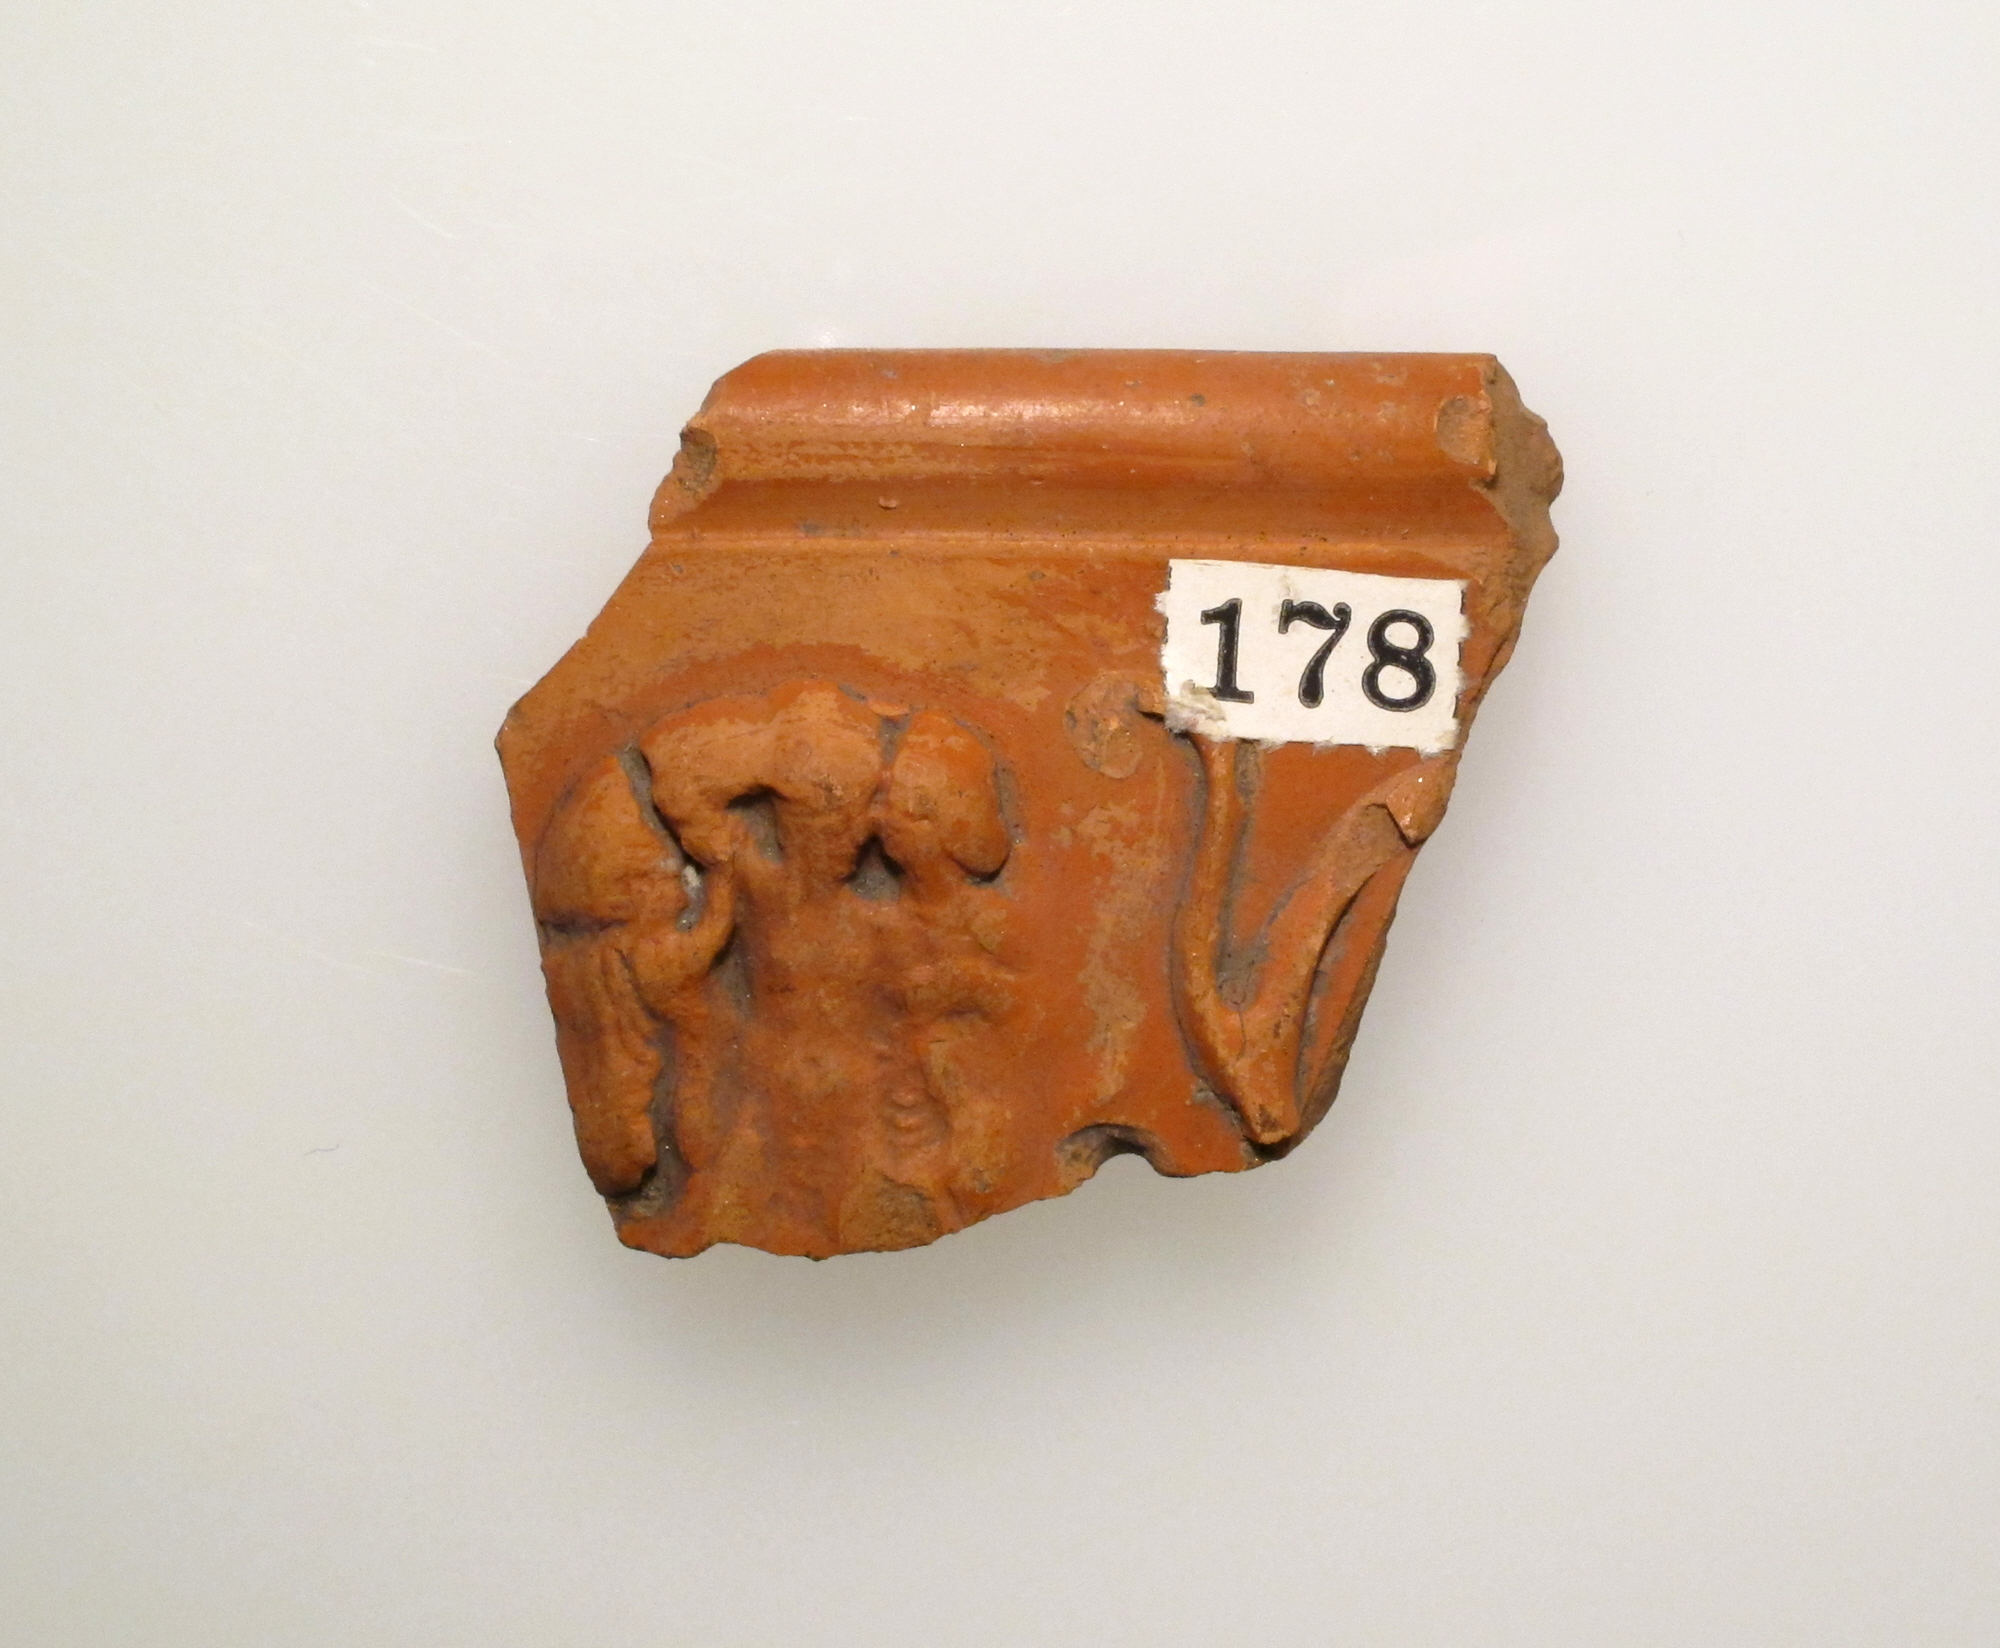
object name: vase fragment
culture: roman, gaul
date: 120 BCE-300 CE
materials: terracotta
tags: children